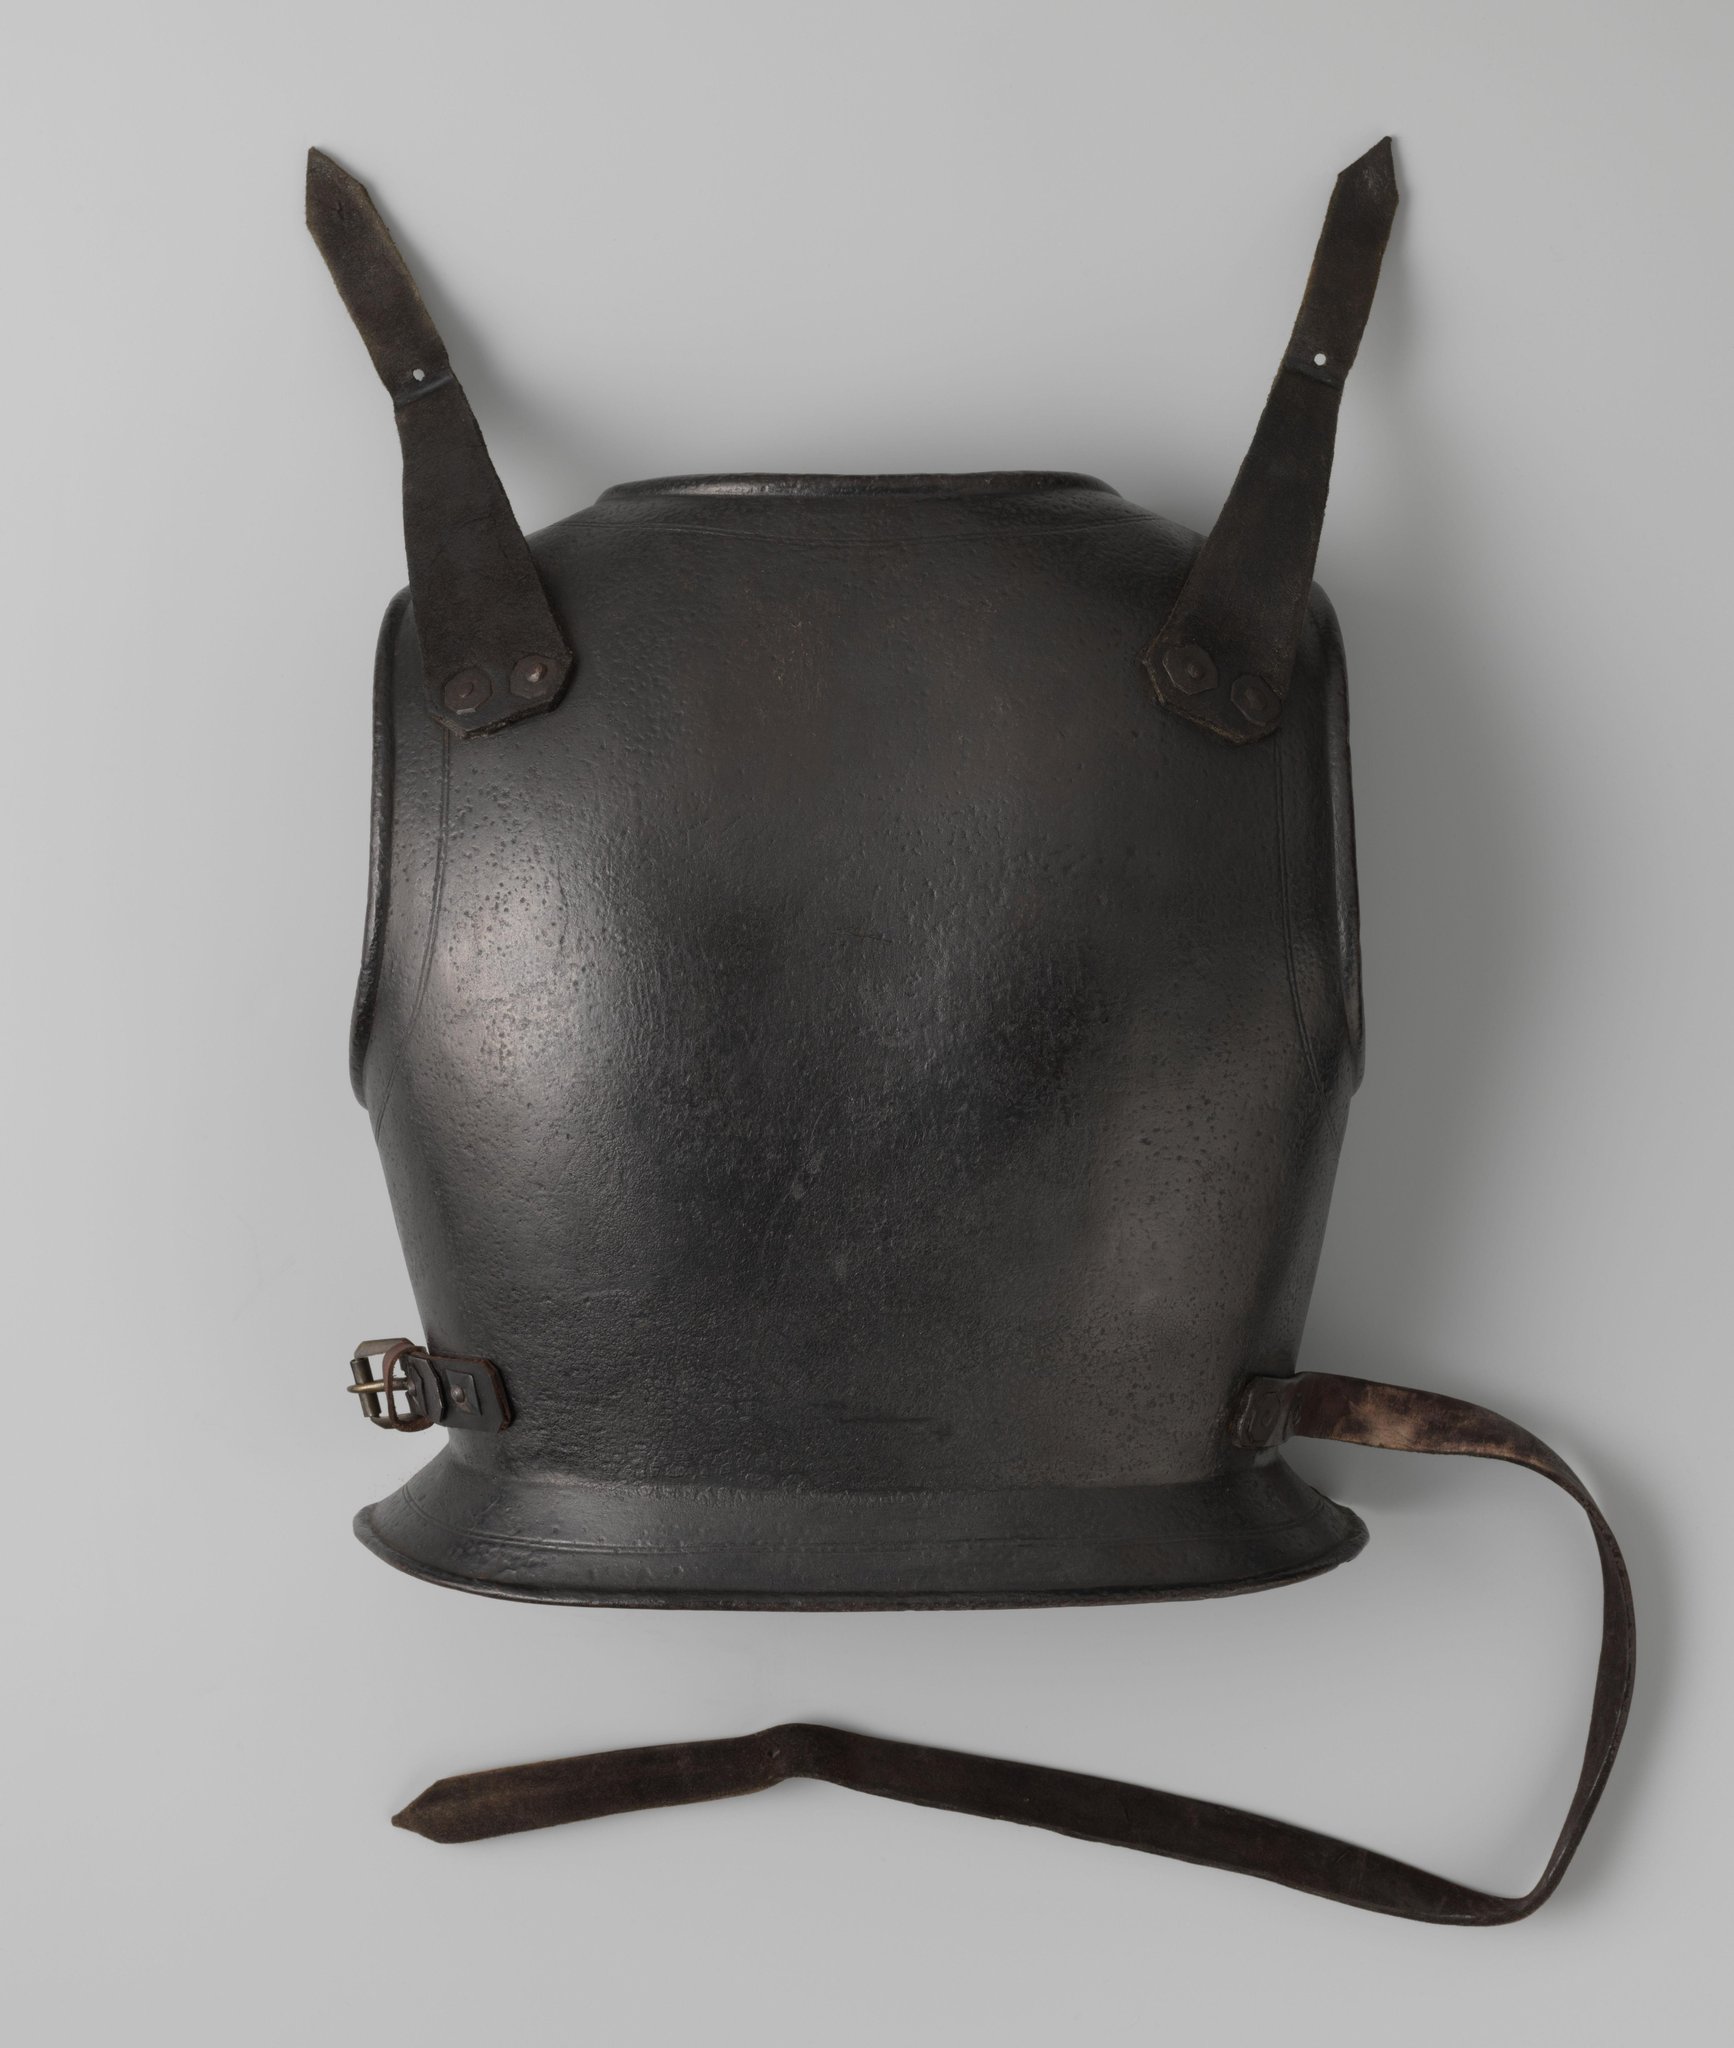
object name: backplate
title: Rugplaat van het harnas van Piet Hein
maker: Anonymous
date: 1600-1629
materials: iron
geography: netherlands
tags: delfshaven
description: Kurasachterstuk van een zwart geverfde wapenrusting, naar men wil van Piet Hein. Het kurasachterstuk hoort bij vijf delen van de wapenrustin (NG-NM-527-A t/m NG-NM-527-F).